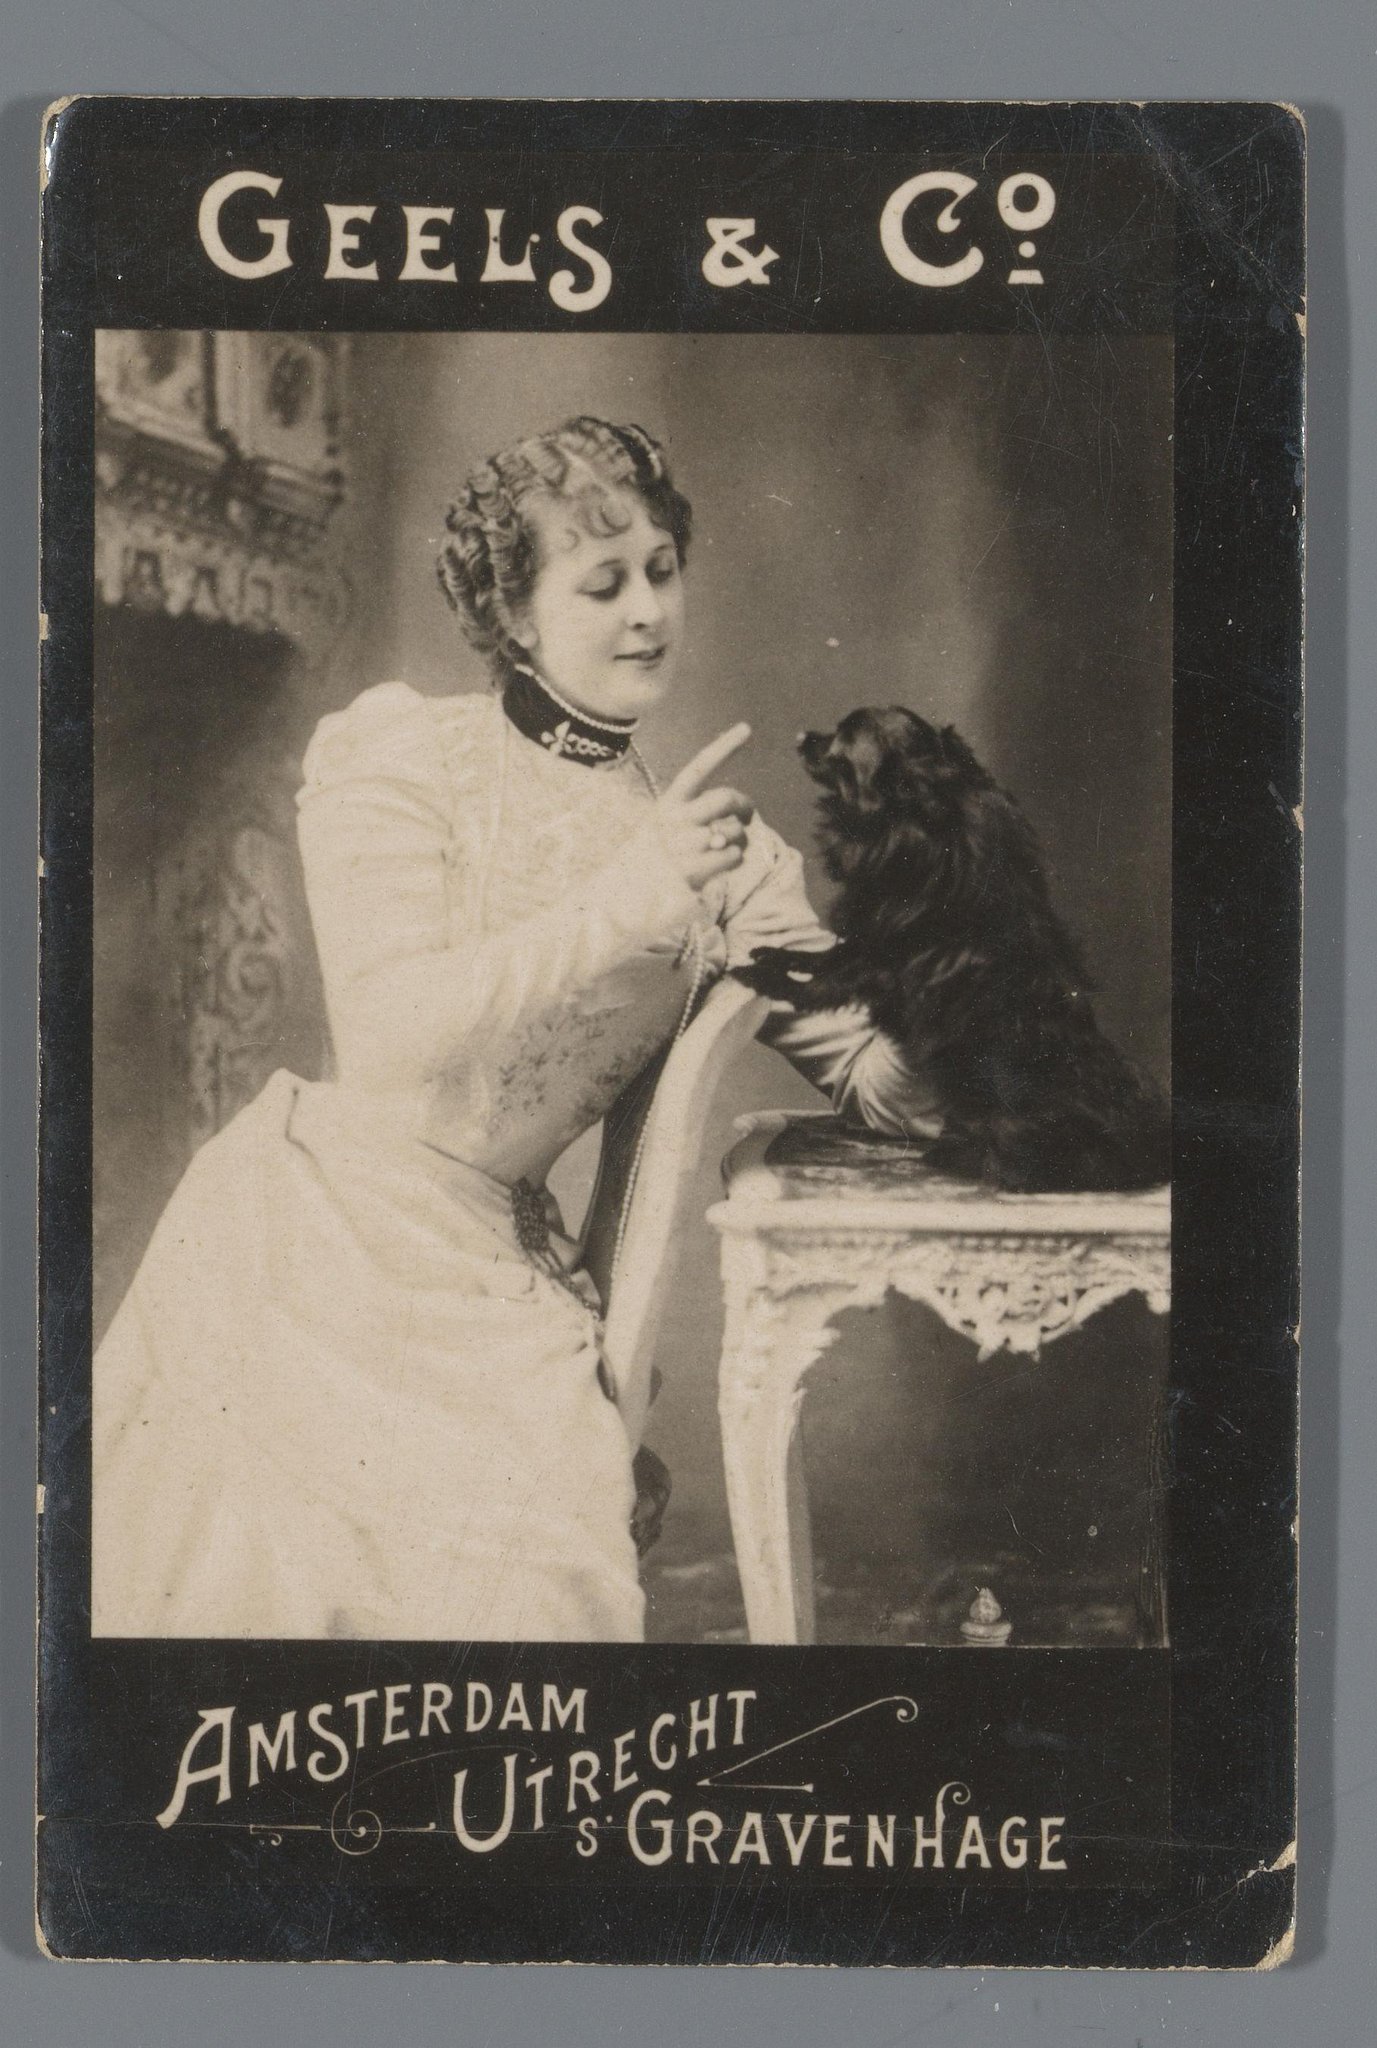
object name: photograph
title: Onbekende vrouw zittend op een stoel met naast haar een hond op een tafel, reclame voor Geels & Co.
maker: Anonymous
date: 1895-1910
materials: paper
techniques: gelatin silver print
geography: netherlands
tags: boy (child between toddler and youth), netherlands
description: Dergelijke foto's stonden bekend als 'zwartjes'. Men verkreeg ze bij aanschaf van bepaalde merken thee, cacao, sigaretten, beschuit, etc. om te verzamelen. Er waren speciaal voor de 'zwartjes' verzamelalbums in omloop.